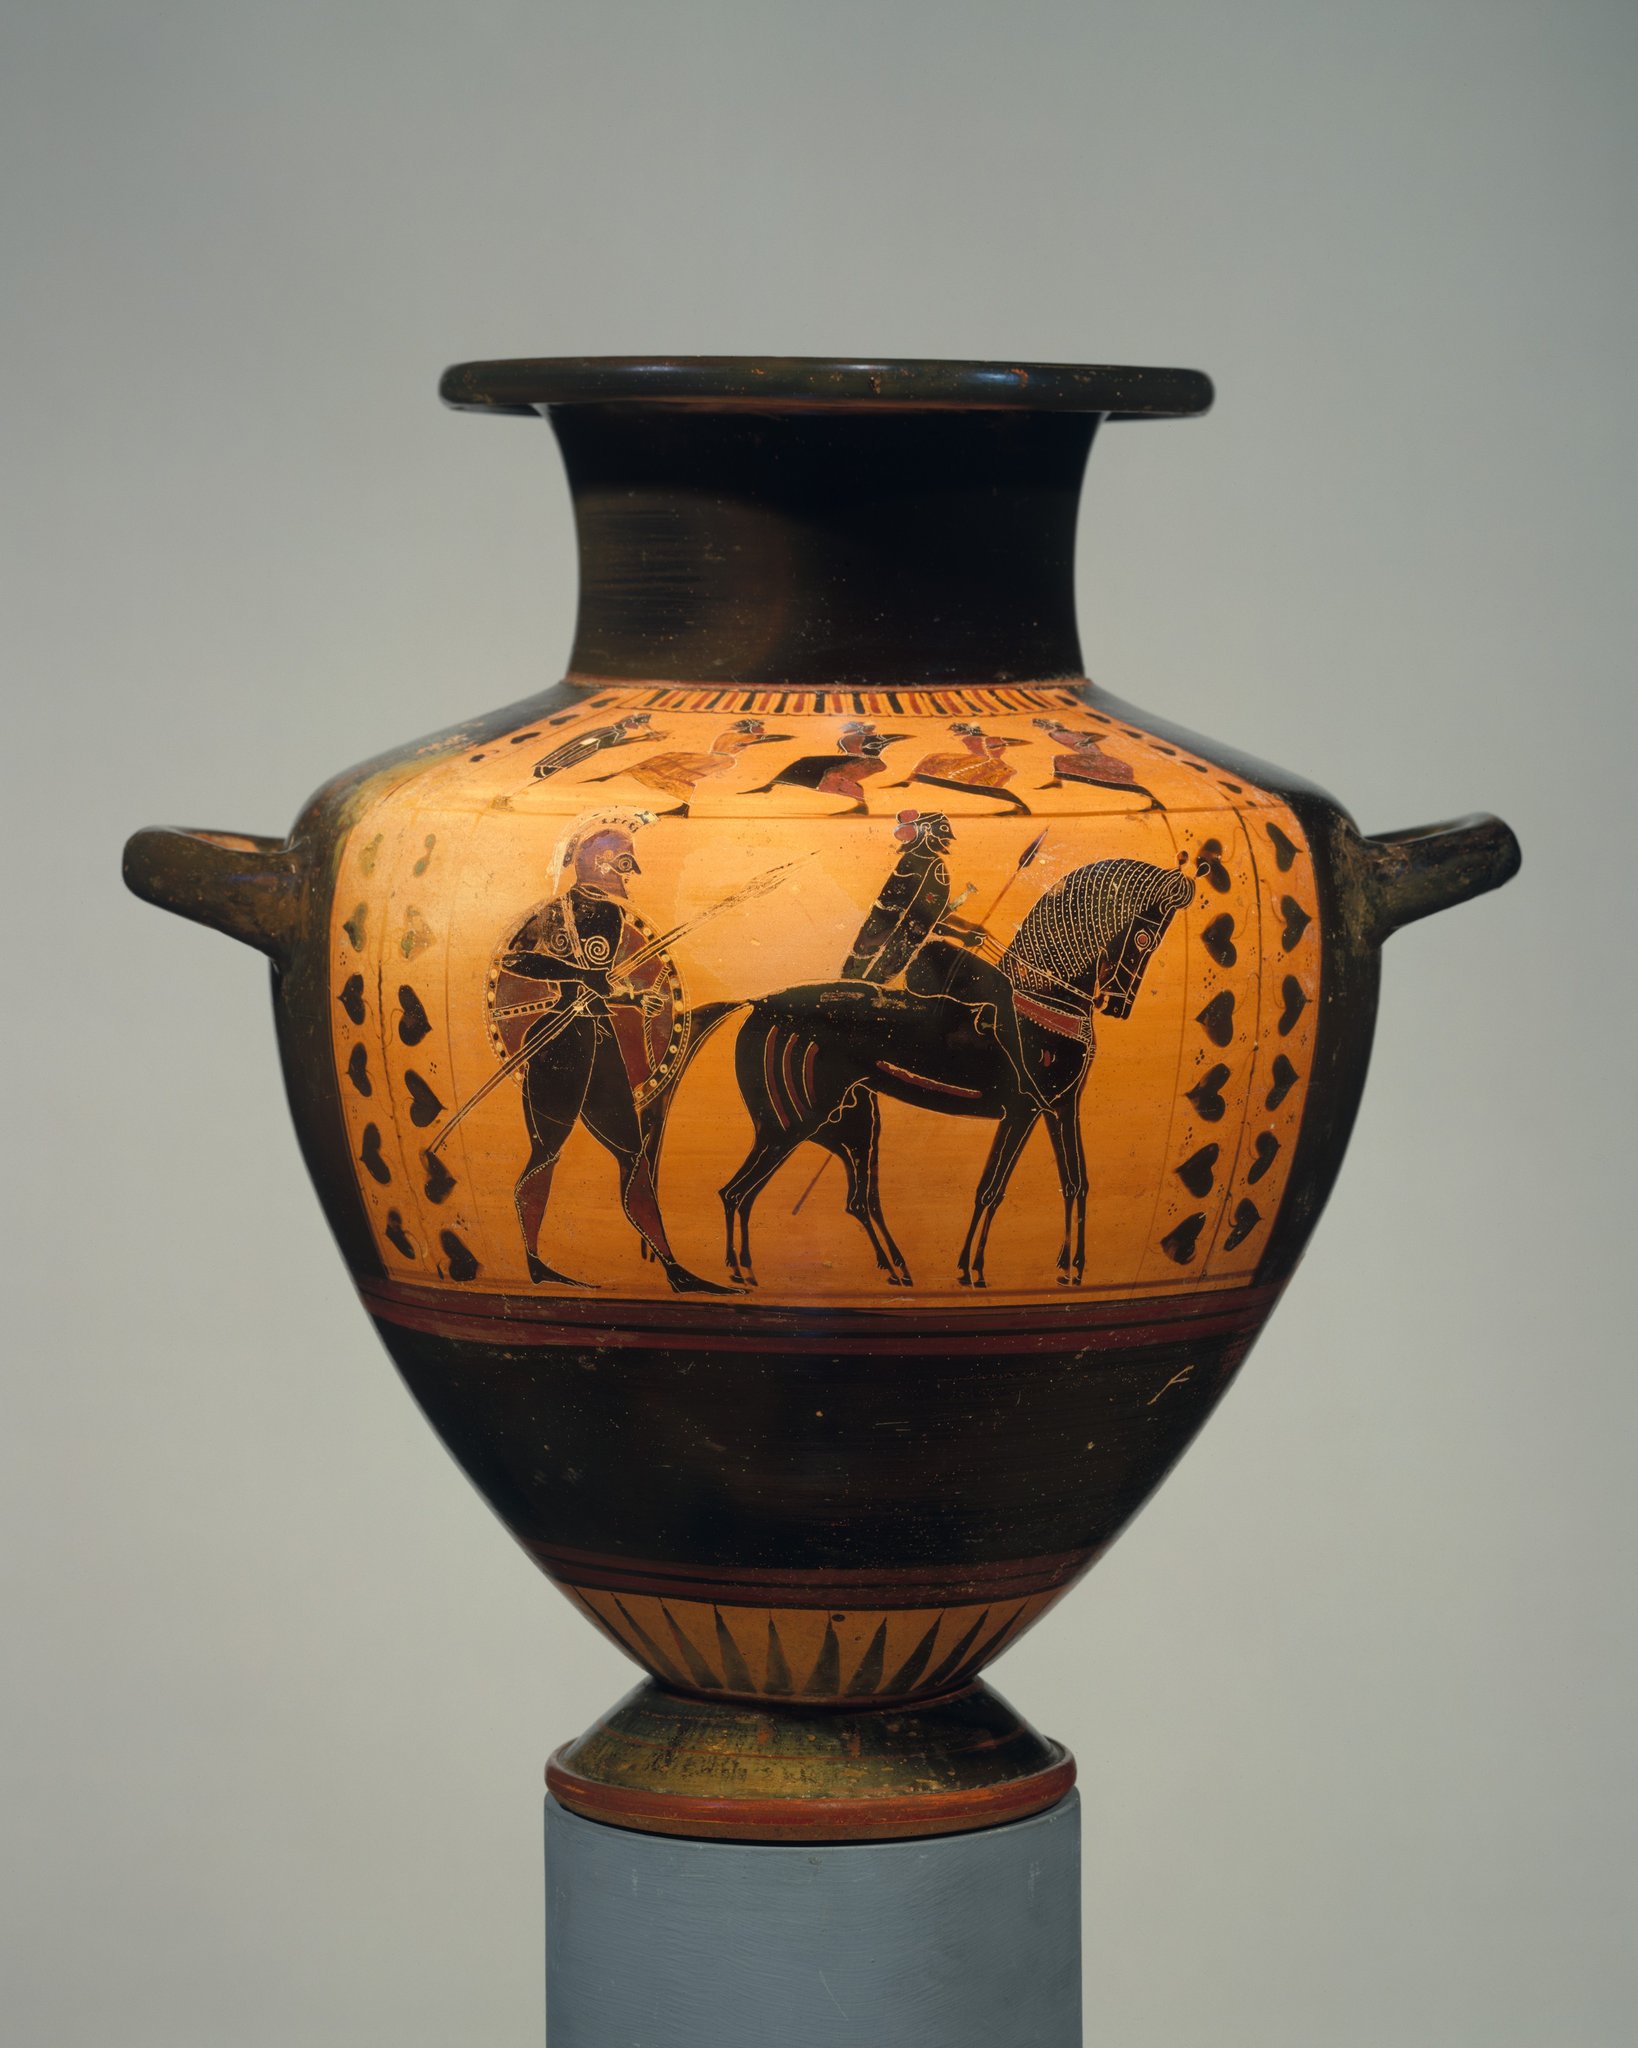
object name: hydria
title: Terracotta hydria (water jar)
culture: greek, attic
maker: lydos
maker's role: artist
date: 560 BCE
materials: terracotta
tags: men,women,dancing,horses